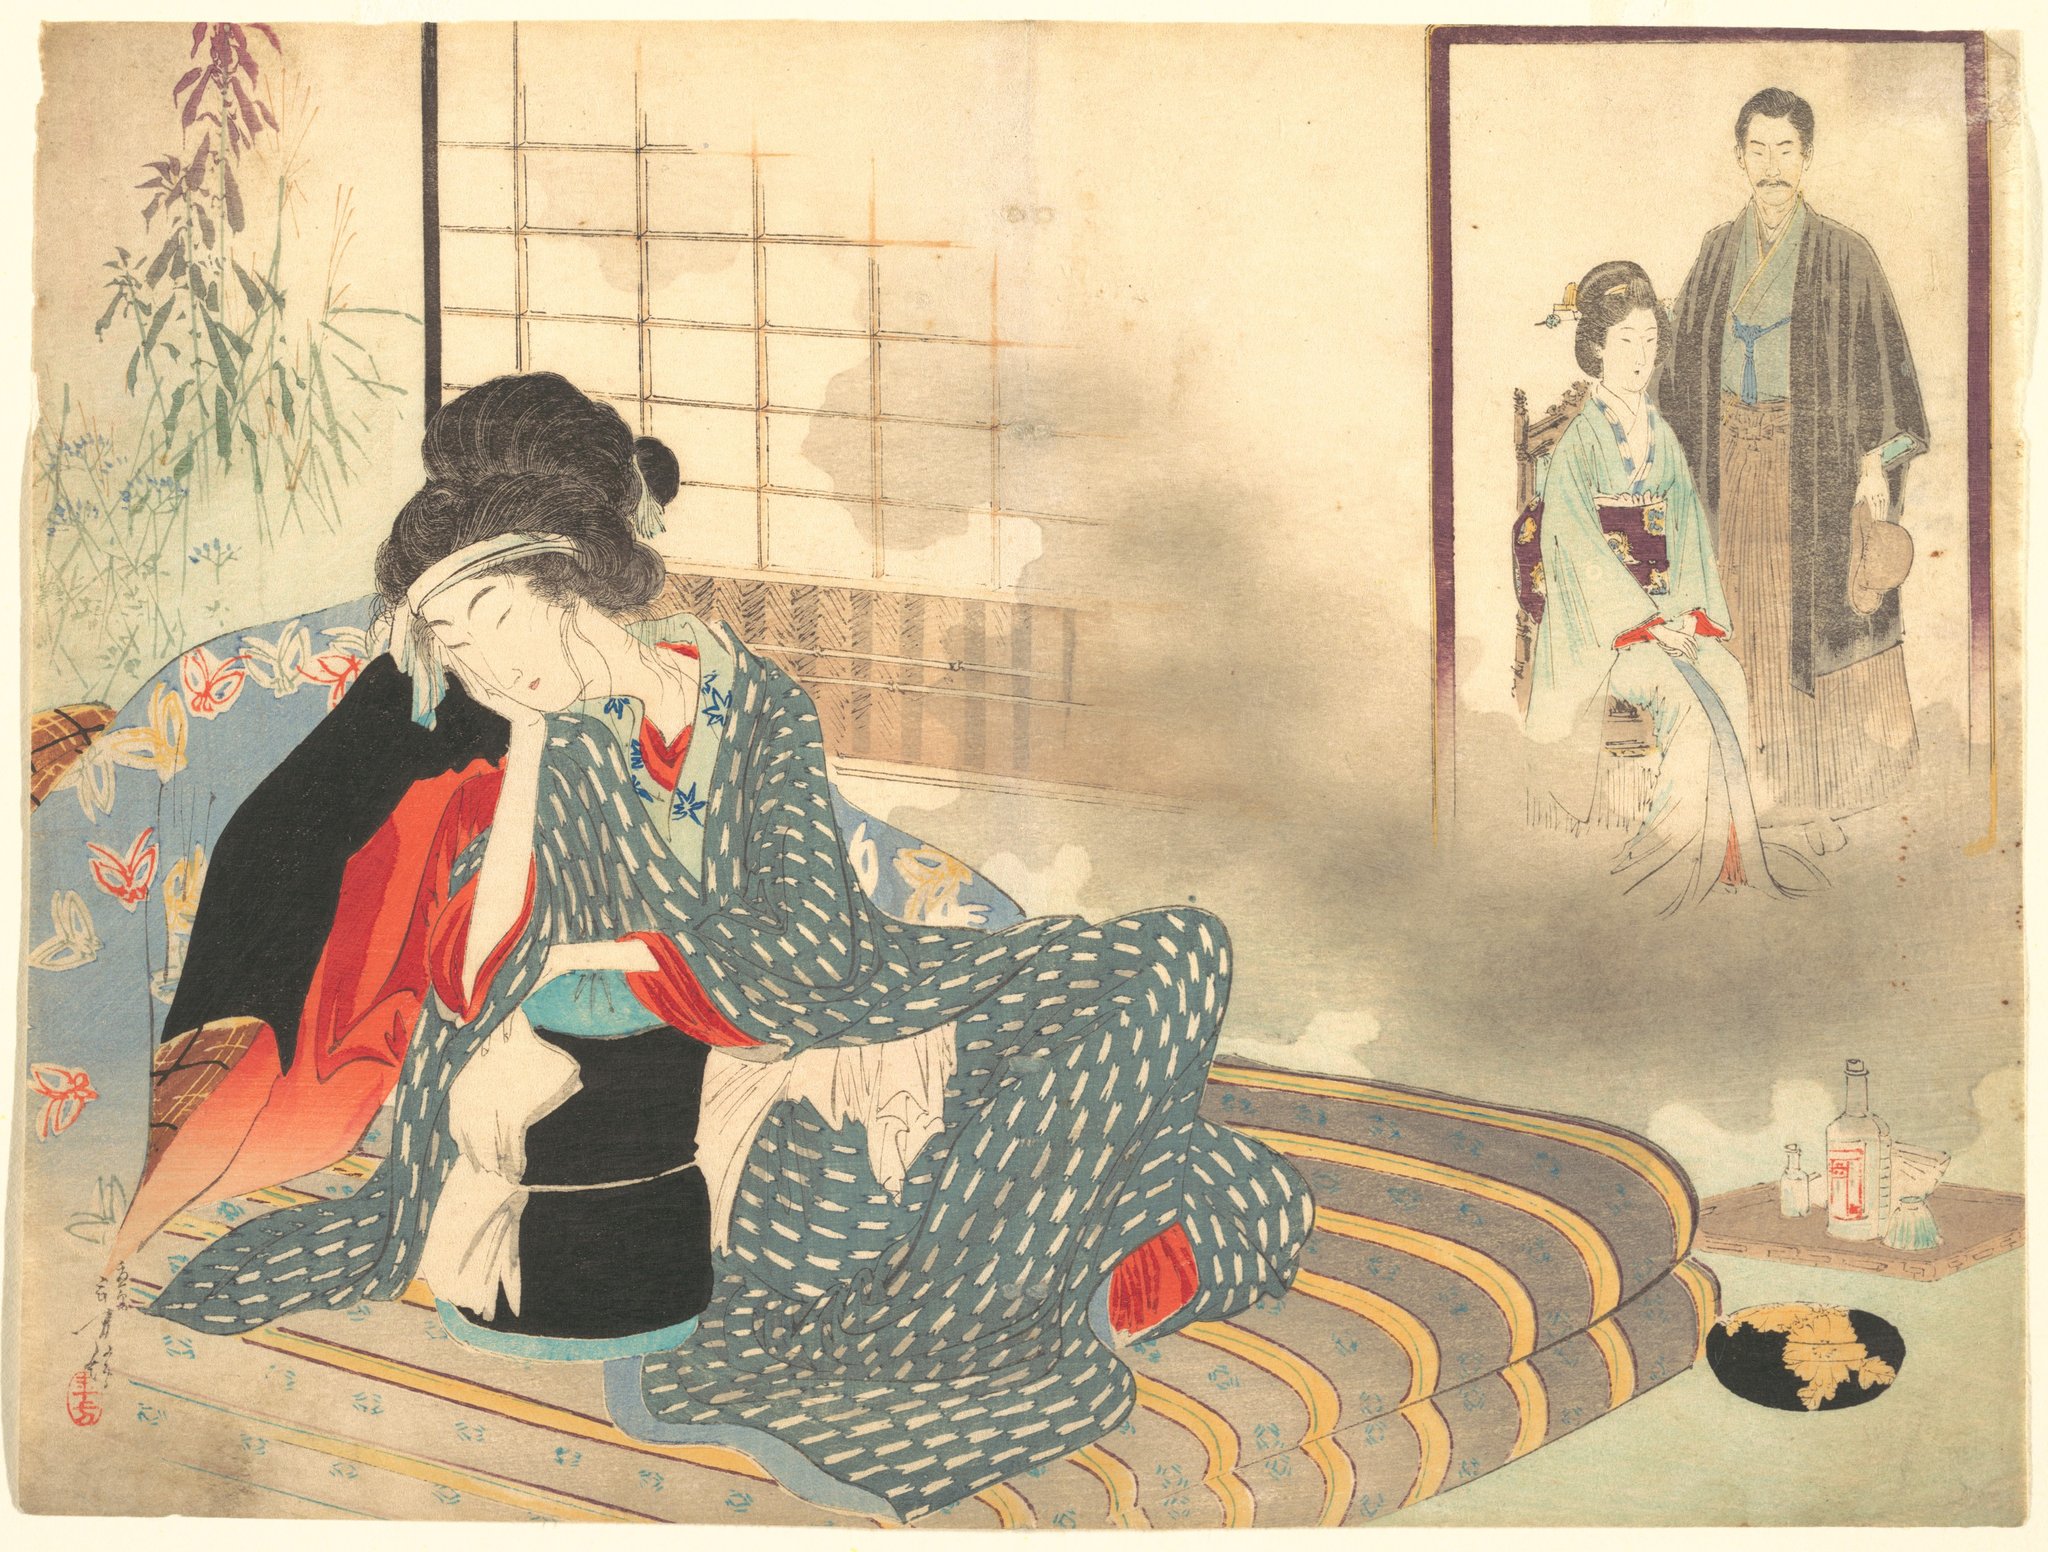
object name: print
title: Surgical Ward' (Gekashitsu) from Bugei Kurabu (Literary Club)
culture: japanese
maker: mizuno toshikata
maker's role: artist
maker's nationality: japanese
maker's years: 1866-1908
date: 1906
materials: ink, paper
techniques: woodblock print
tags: contemplation,illness,men,women